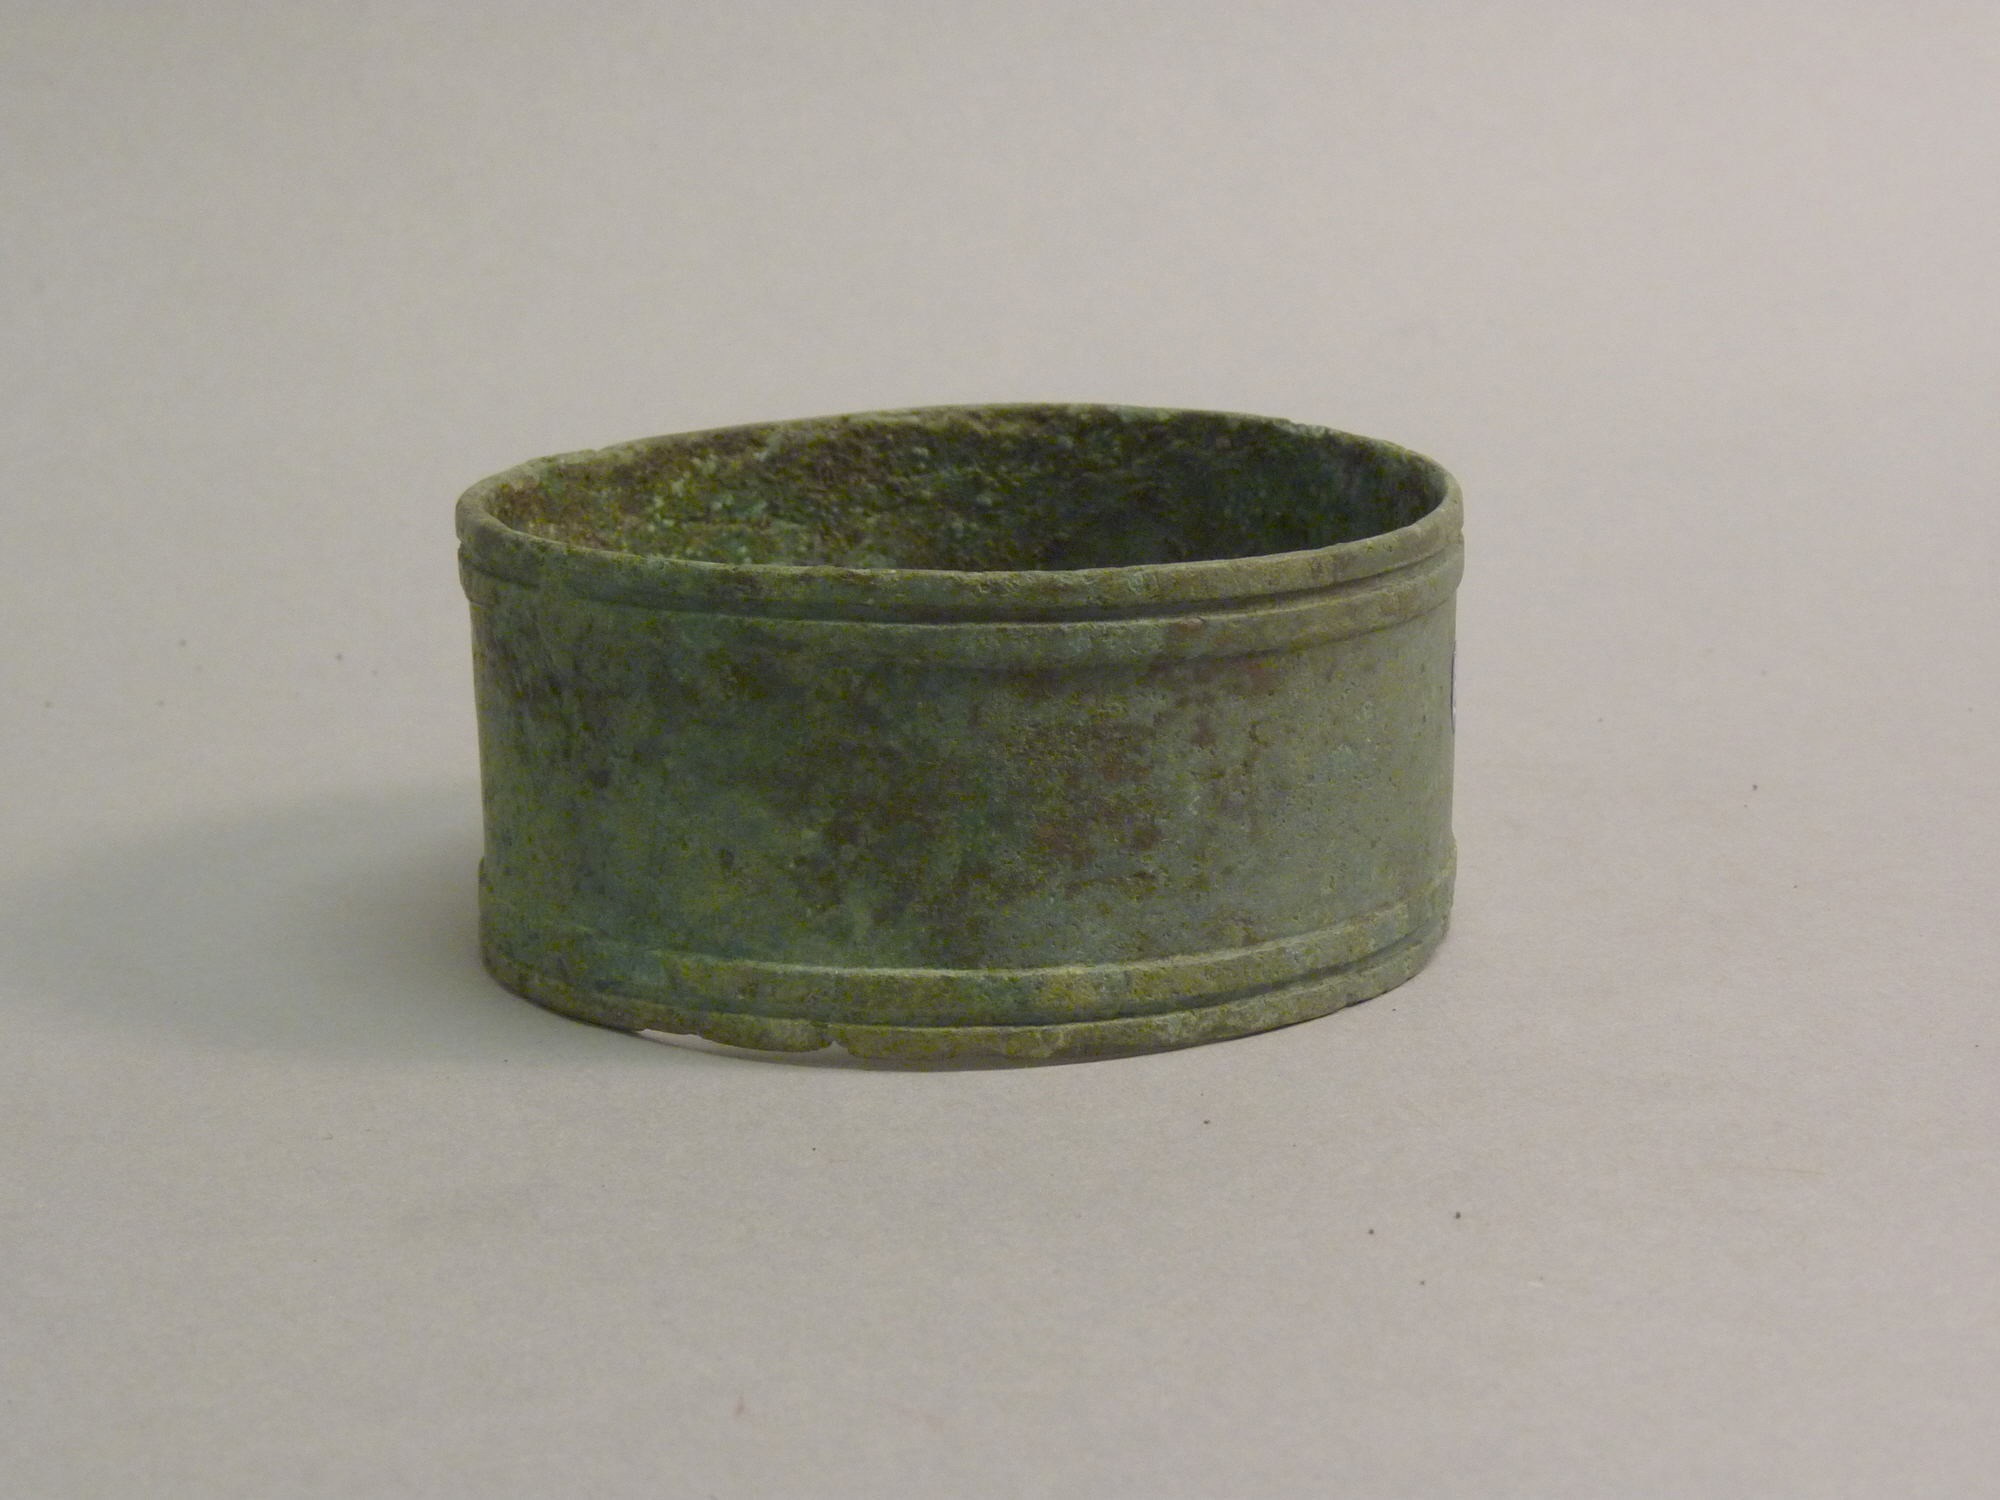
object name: bracelet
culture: thai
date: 500 BCE-300 CE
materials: bronze